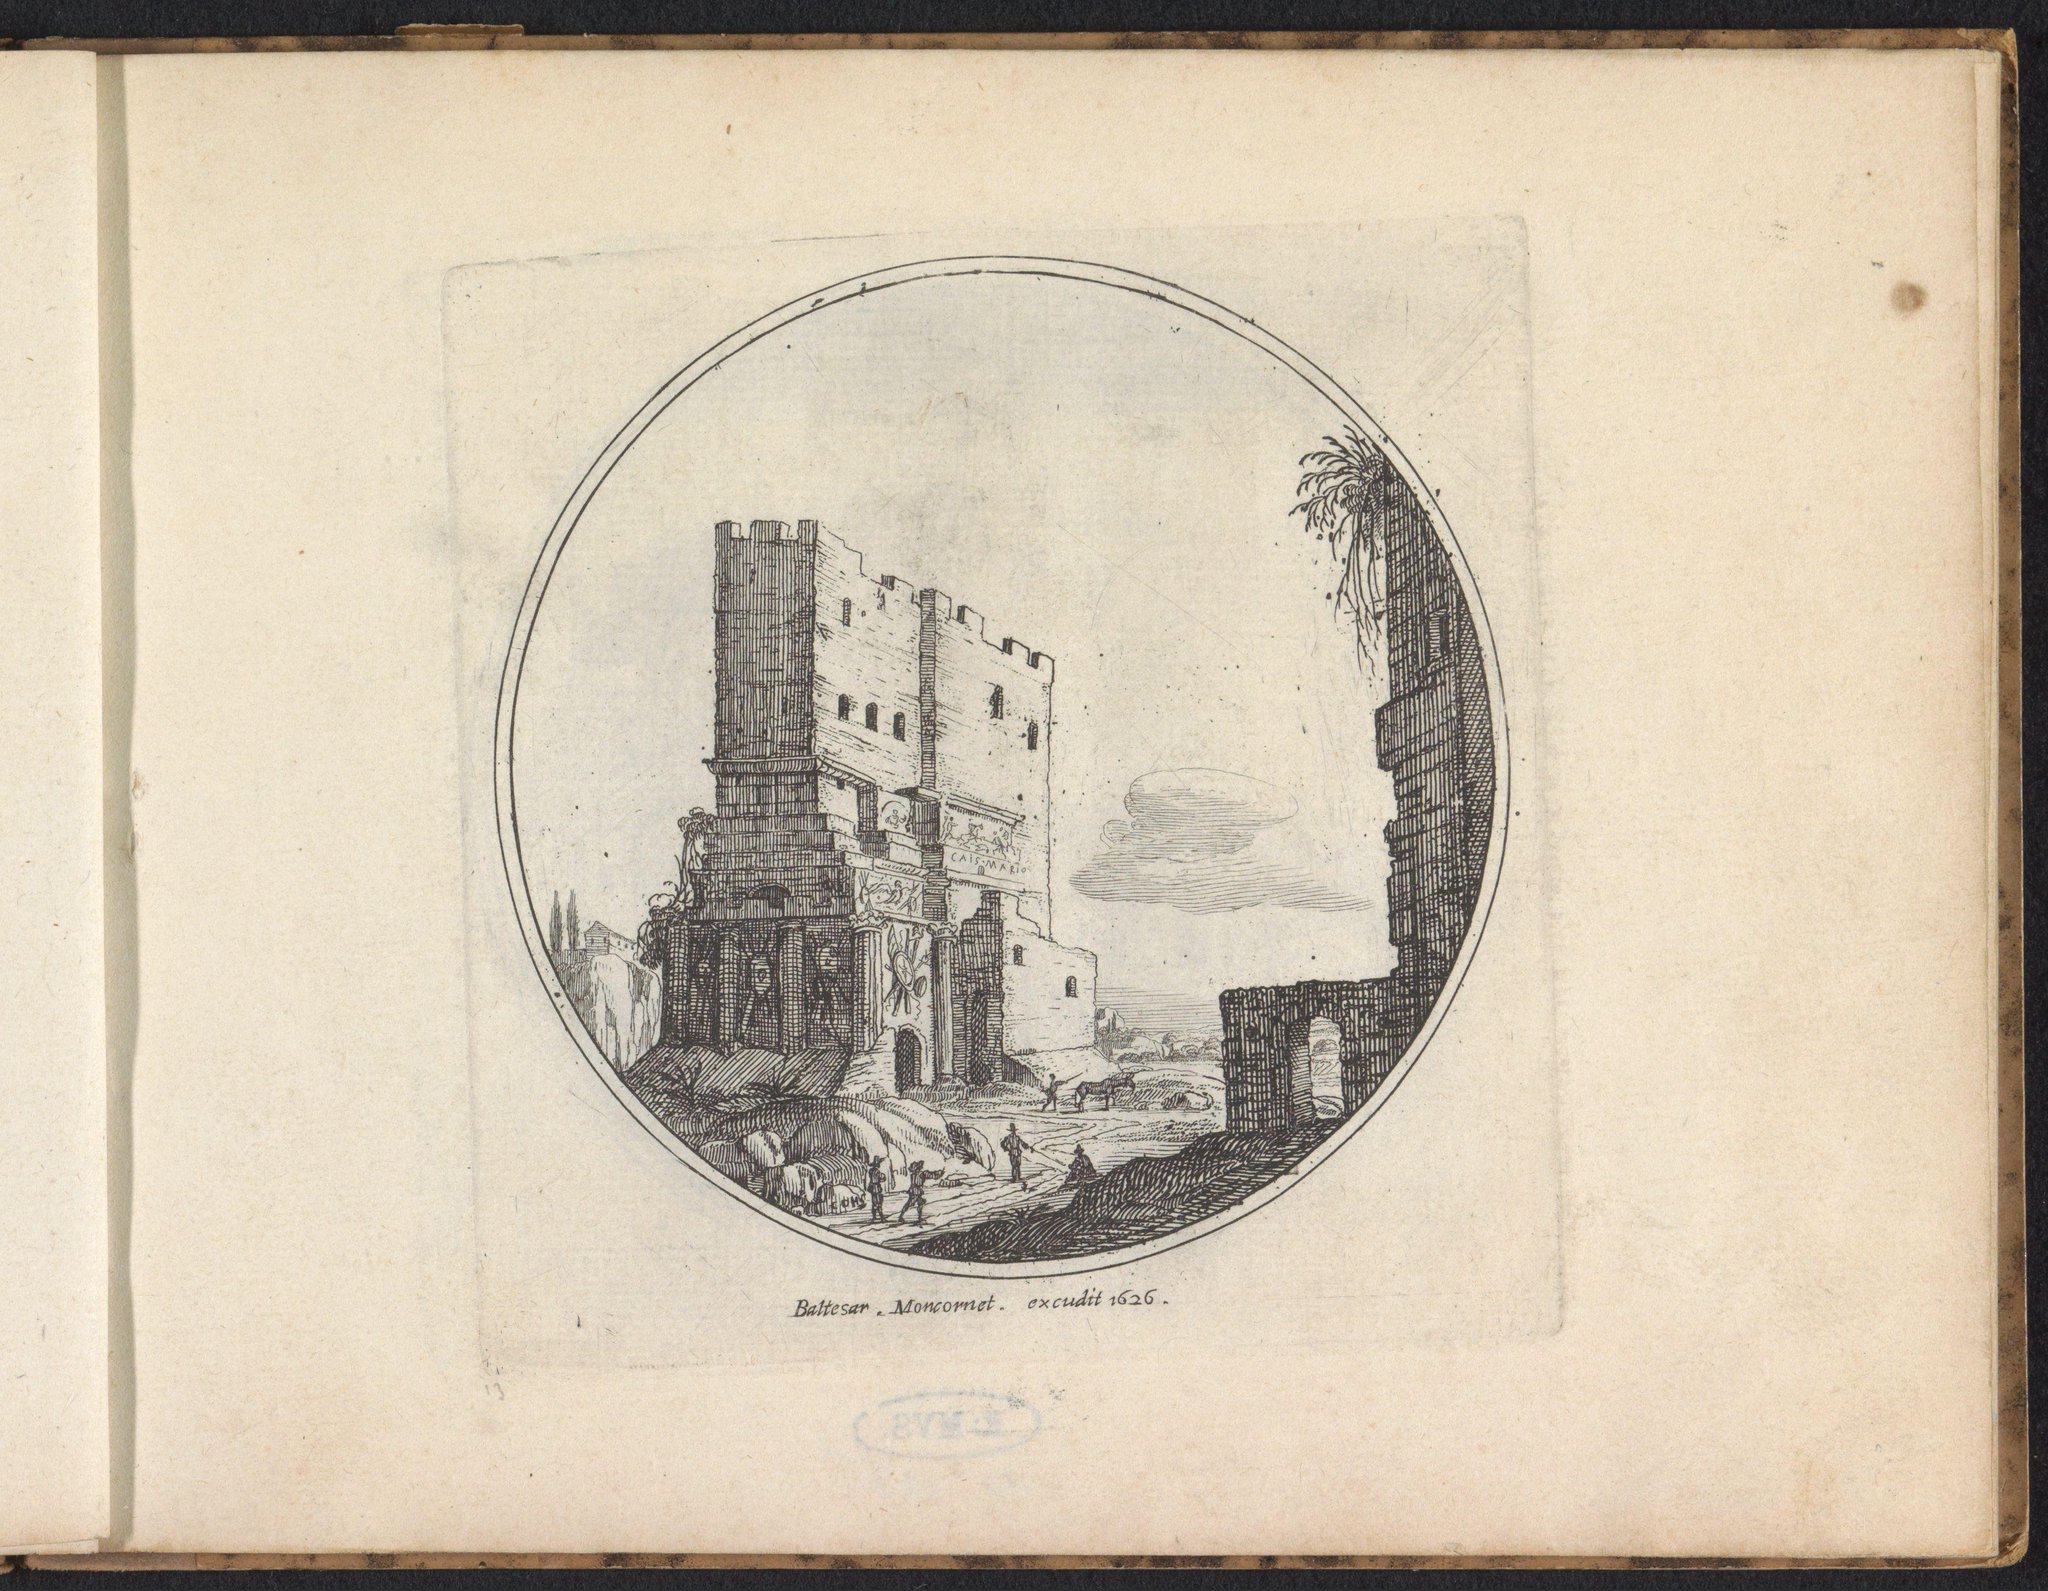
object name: album leaf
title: Landschap met de ruïne 'Cais Mario'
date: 1626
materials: paper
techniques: etching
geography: northern netherlands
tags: landscapes, landscape with ruins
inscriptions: collector's mark: Lugt 2228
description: Landschap met een ruïne. Op de ruïne staat de naam 'Cais Mario'. Op de muur hangen wapentrofeeën. De prent maakt deel uit van een album.